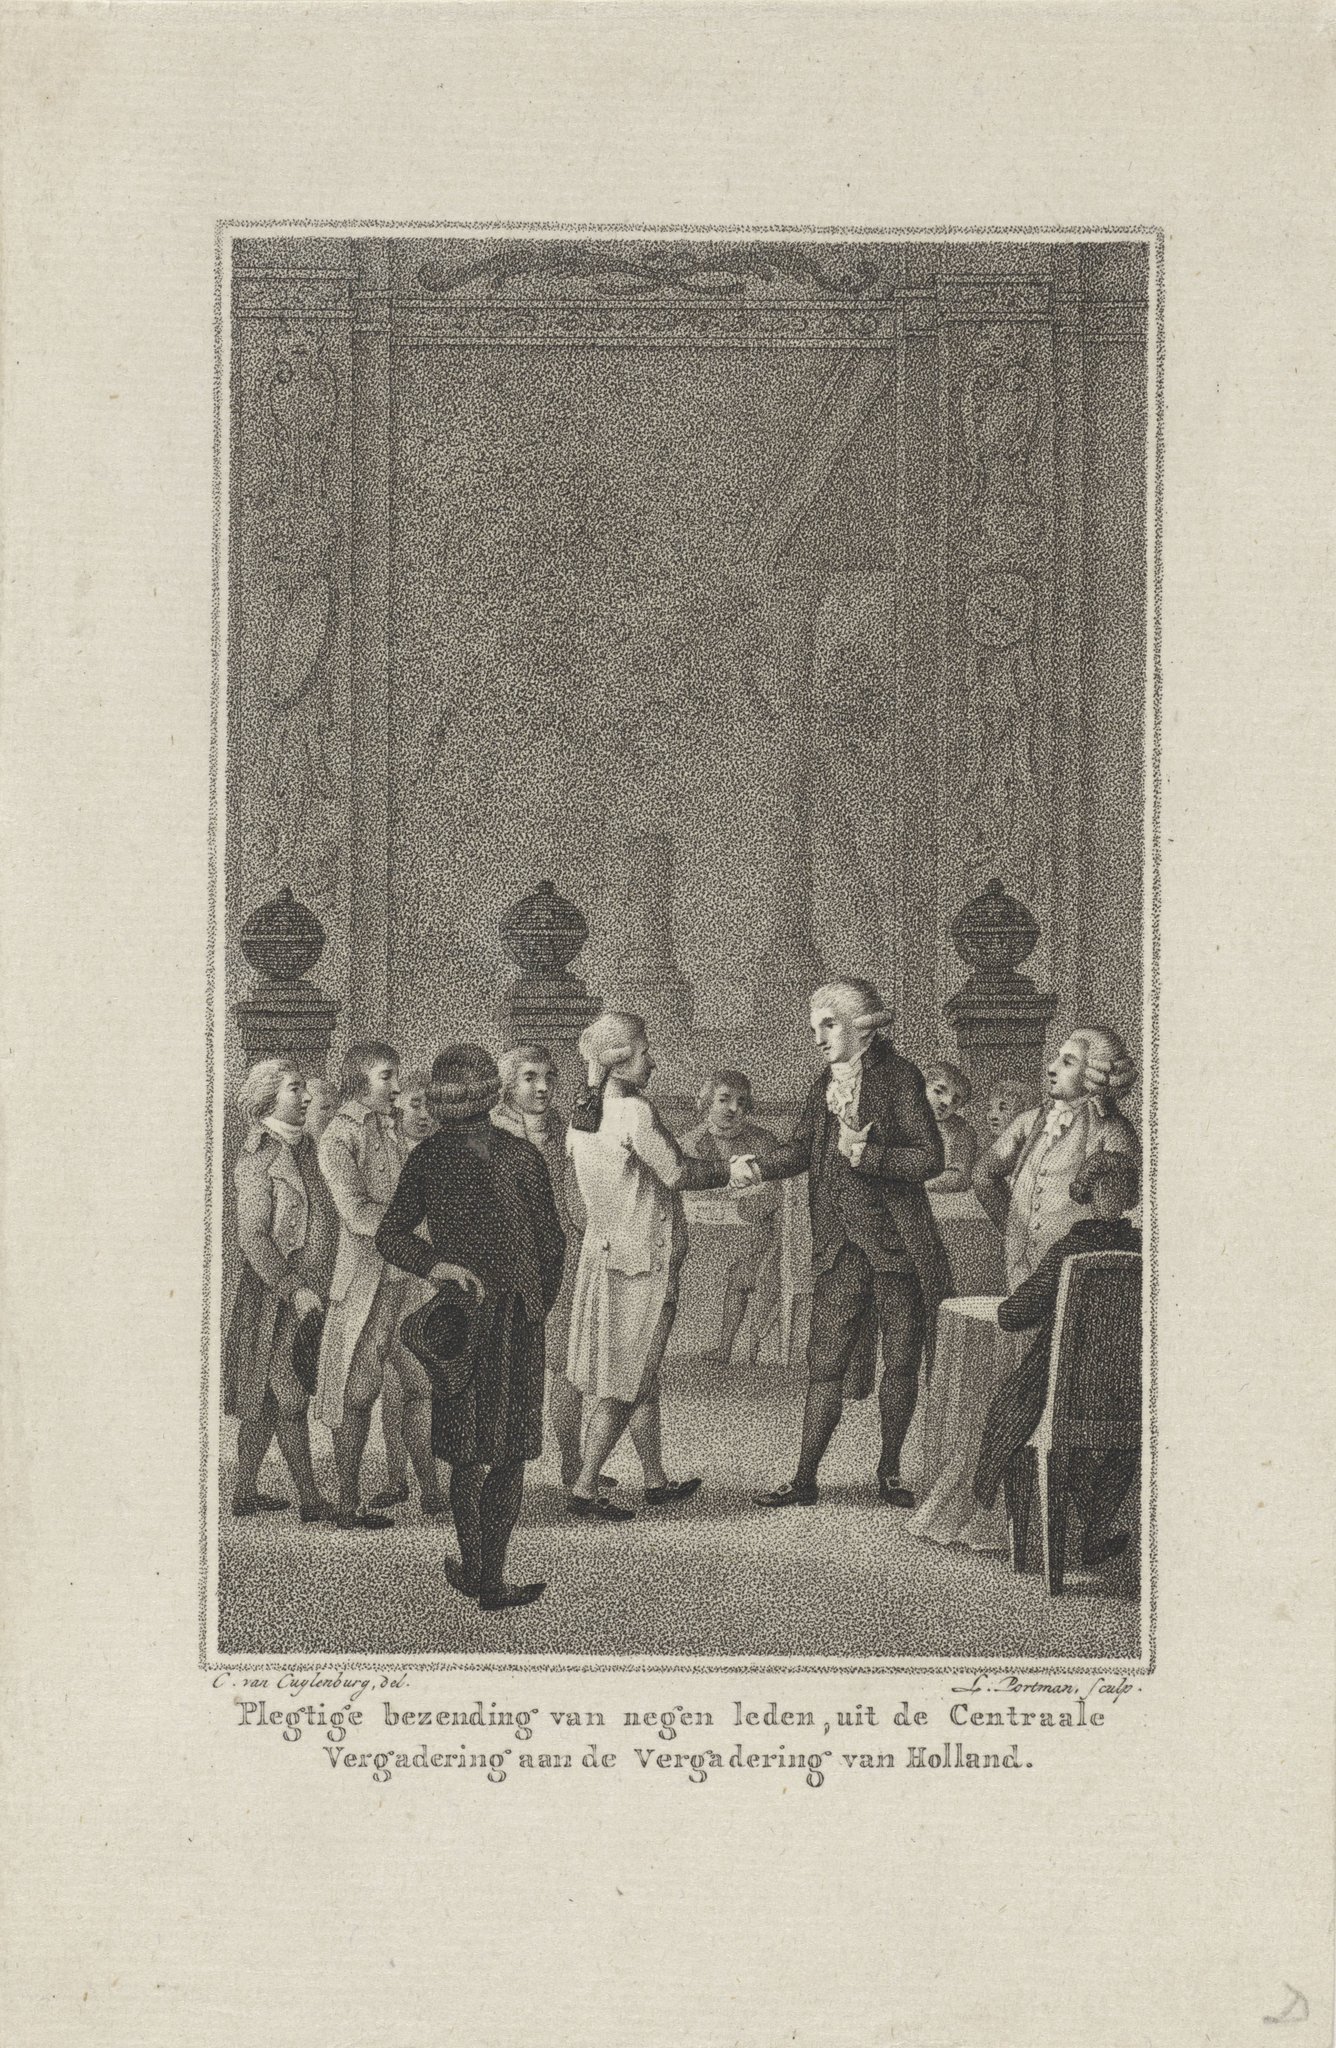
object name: print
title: Ontvangst van leden van de Algemene Centrale Vergadering in de Vergadering van Holland, 1795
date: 1800-1801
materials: paper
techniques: etching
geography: amsterdam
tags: national government, politics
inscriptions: collector's mark: Lugt 2228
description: Illustratie uit: Zillesen, Cornelis. Geschiedenis der Vereenigde Nederlanden, nevens de voornaamste gebeurtenissen in Europa. 6 dln, 1798-1802. Den Haag: J.C. Leeuwestijn, dl. V (1801).